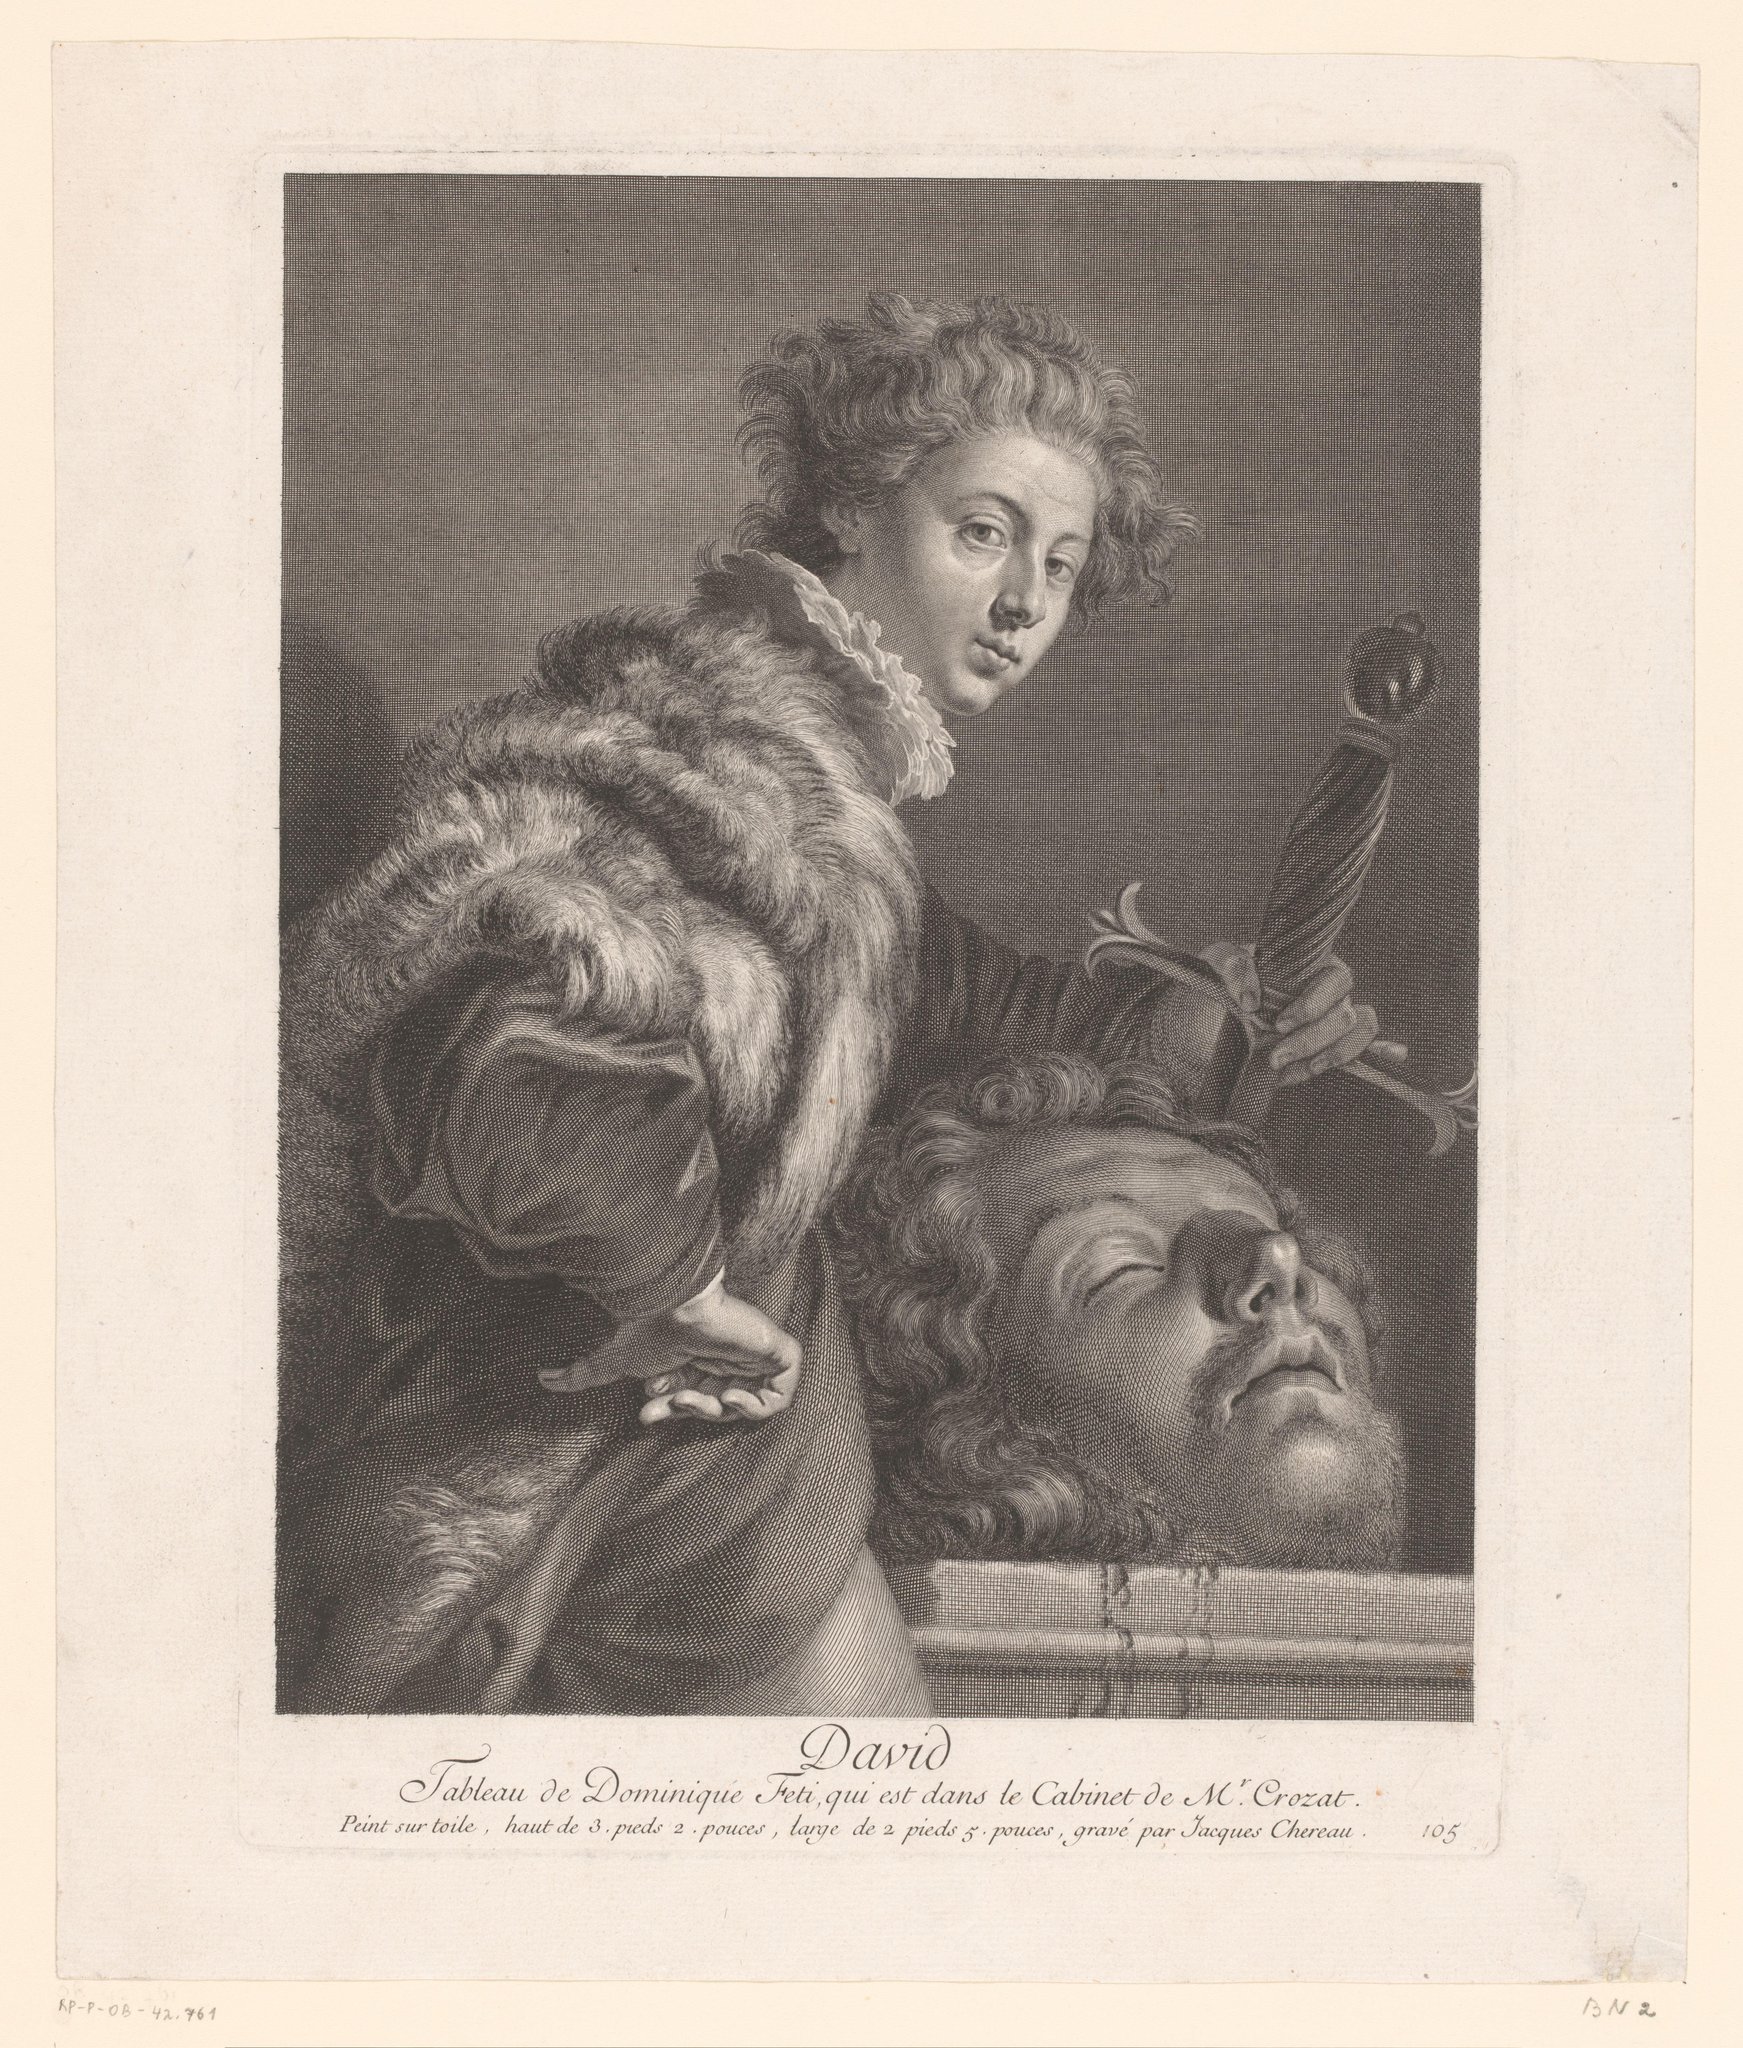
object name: print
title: David met het hoofd van Goliath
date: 1727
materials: paper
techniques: engraving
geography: france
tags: david with goliath's head, hacking and thrusting weapons: sword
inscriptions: collector's mark: Lugt 2228